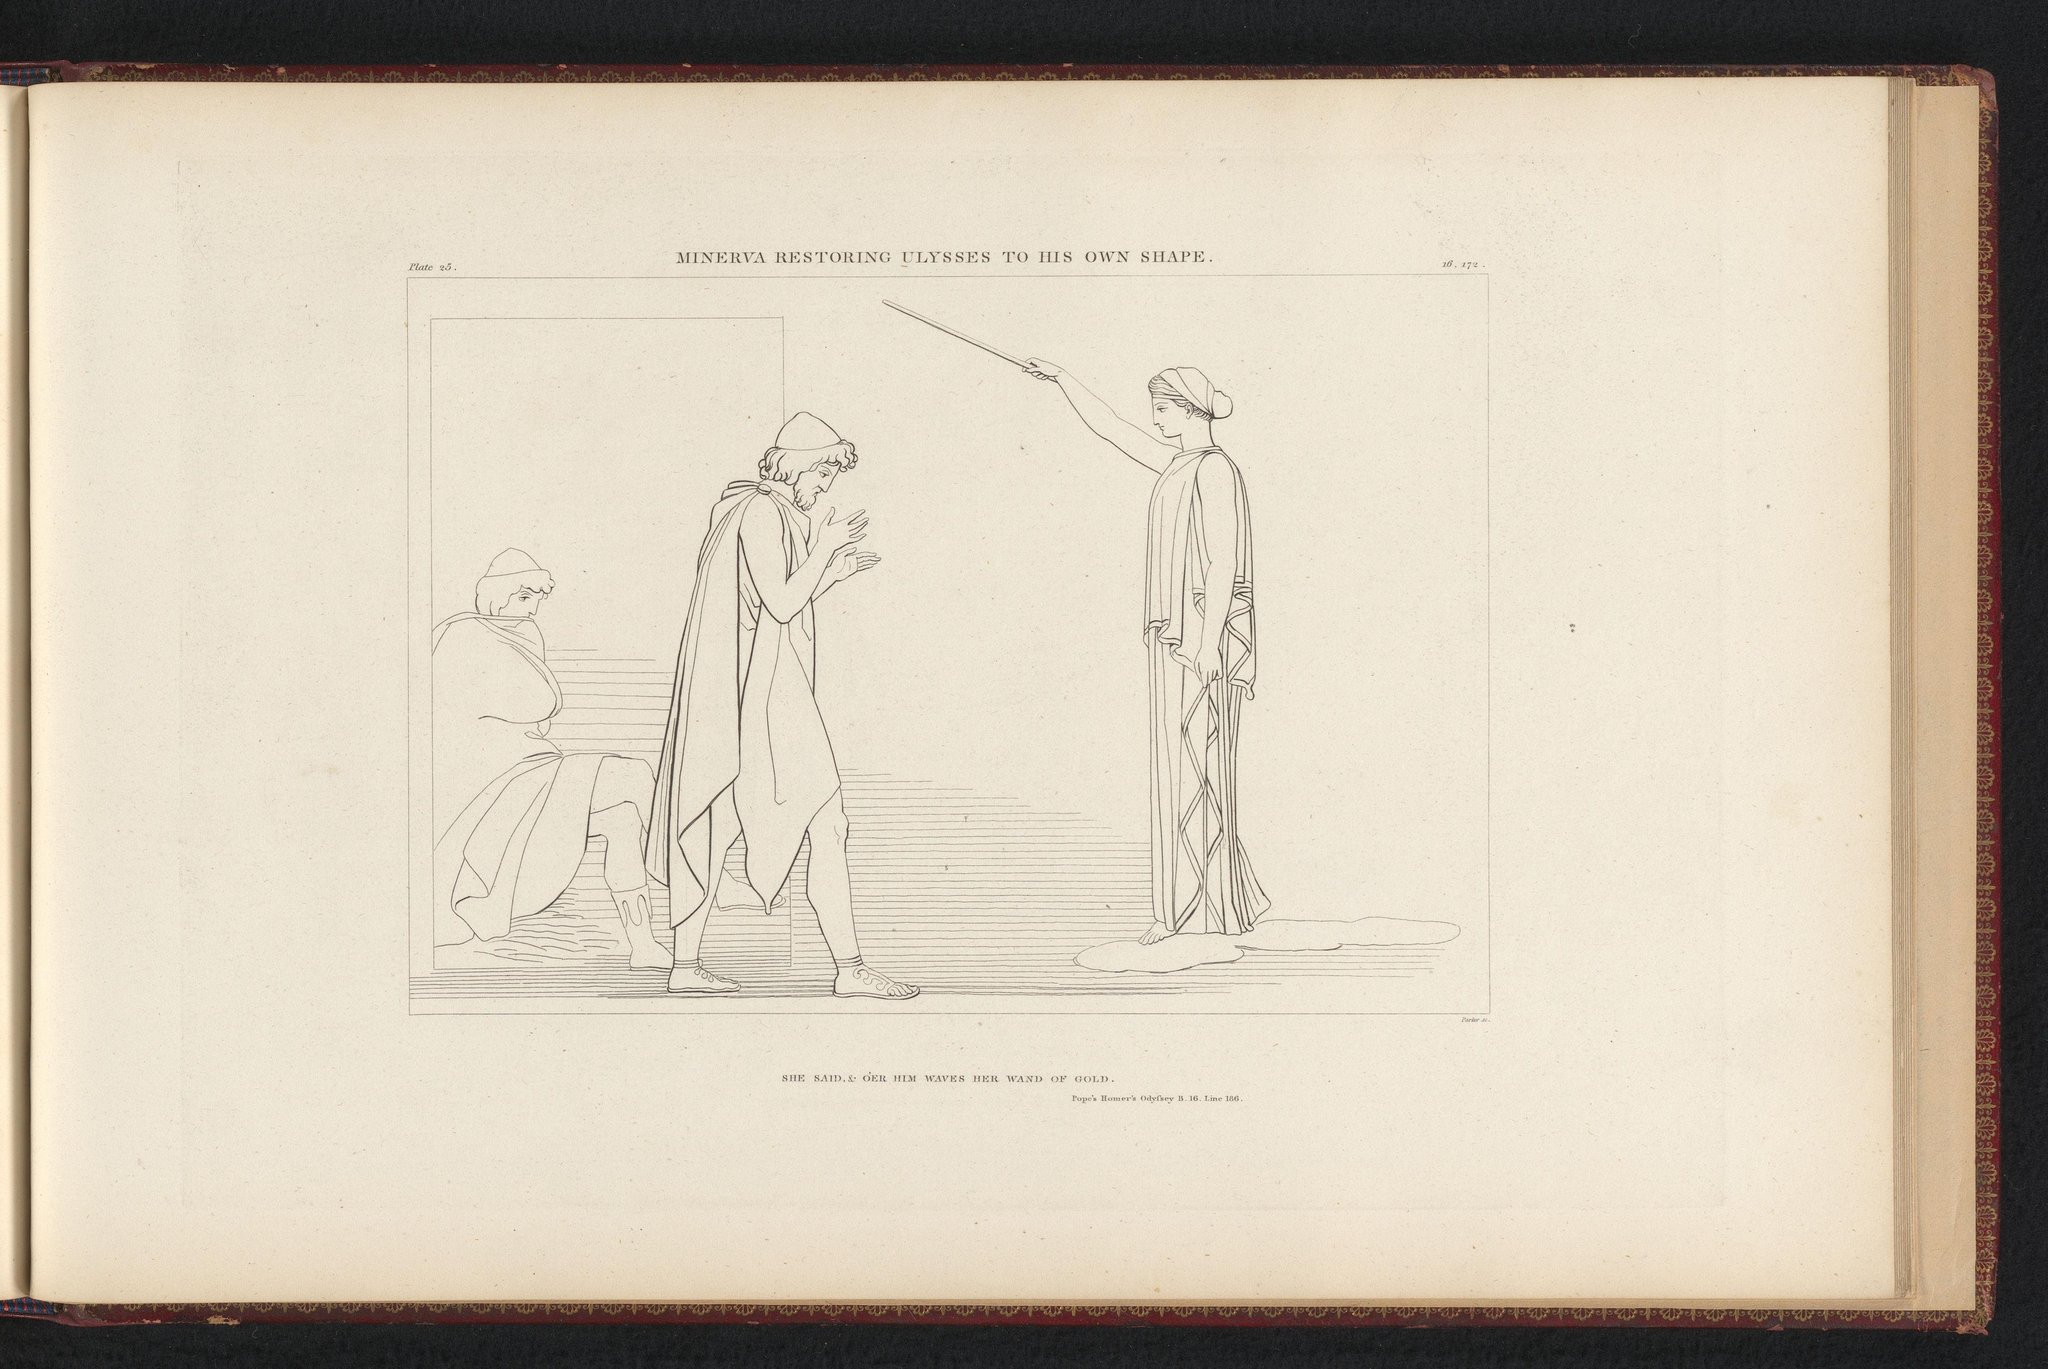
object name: album leaf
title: Minerva verandert het gelaat van Odysseus in een oud man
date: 1805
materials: paper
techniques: etching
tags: ulysses awakes on the shore where the phaeacians left him; minerva disguises him as an old beggar (homer, odyssey xiii)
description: Prent maakt onderdeel uit van een serie met 34 prenten over de Odyssee, geschreven door Homerus.